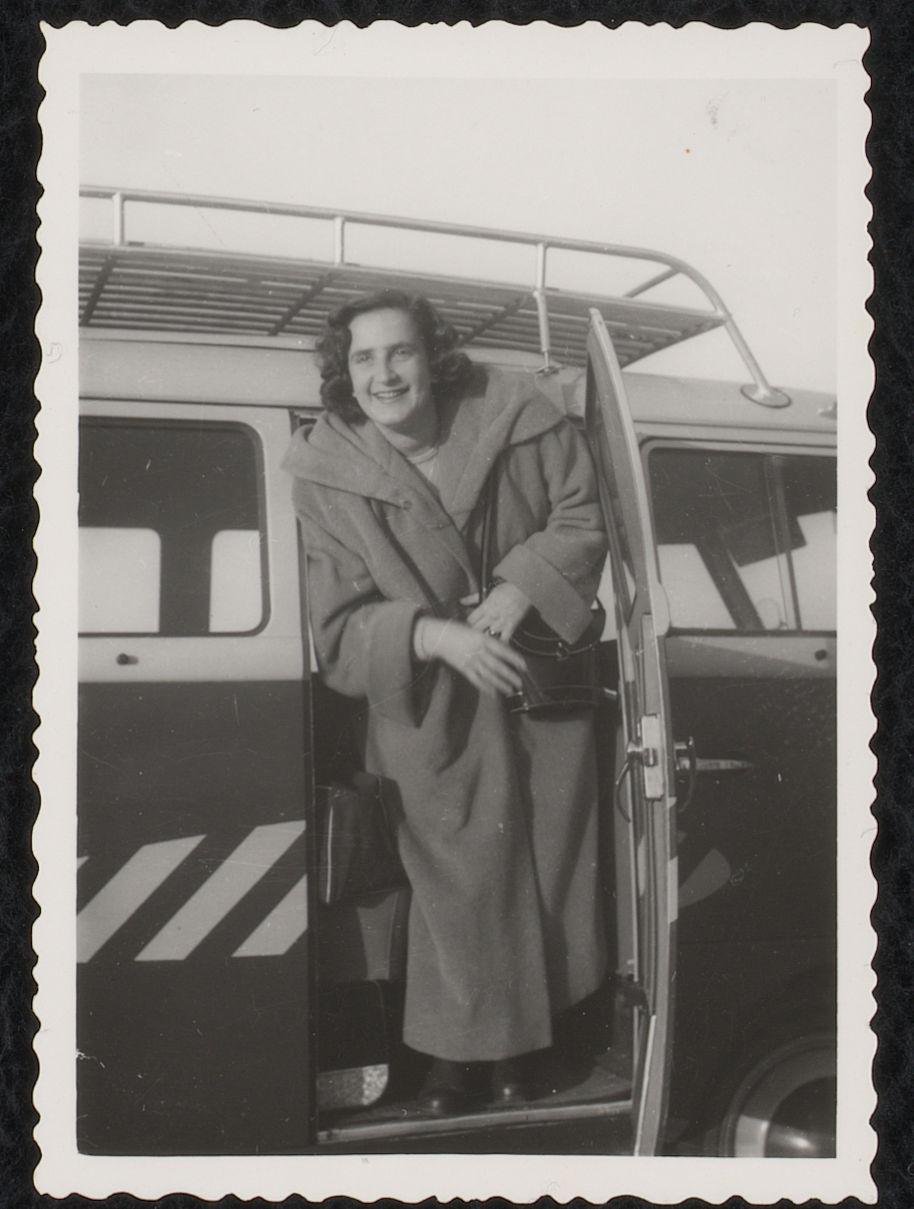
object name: photograph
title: Isabel Wachenheimer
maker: Anonymous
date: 1947-1955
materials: photographic support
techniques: gelatin silver print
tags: leiden, isabel wachenheimer-elon, historical persons - bb - woman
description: Portret van Isabel Wachenheimer, staande in de deur van een auto of bus. Waarschijnlijk ten tijde van haar werk bij de KLM in Tel Aviv. Losse foto in het album half formaat, kunstlederen omslag met koordbinding.